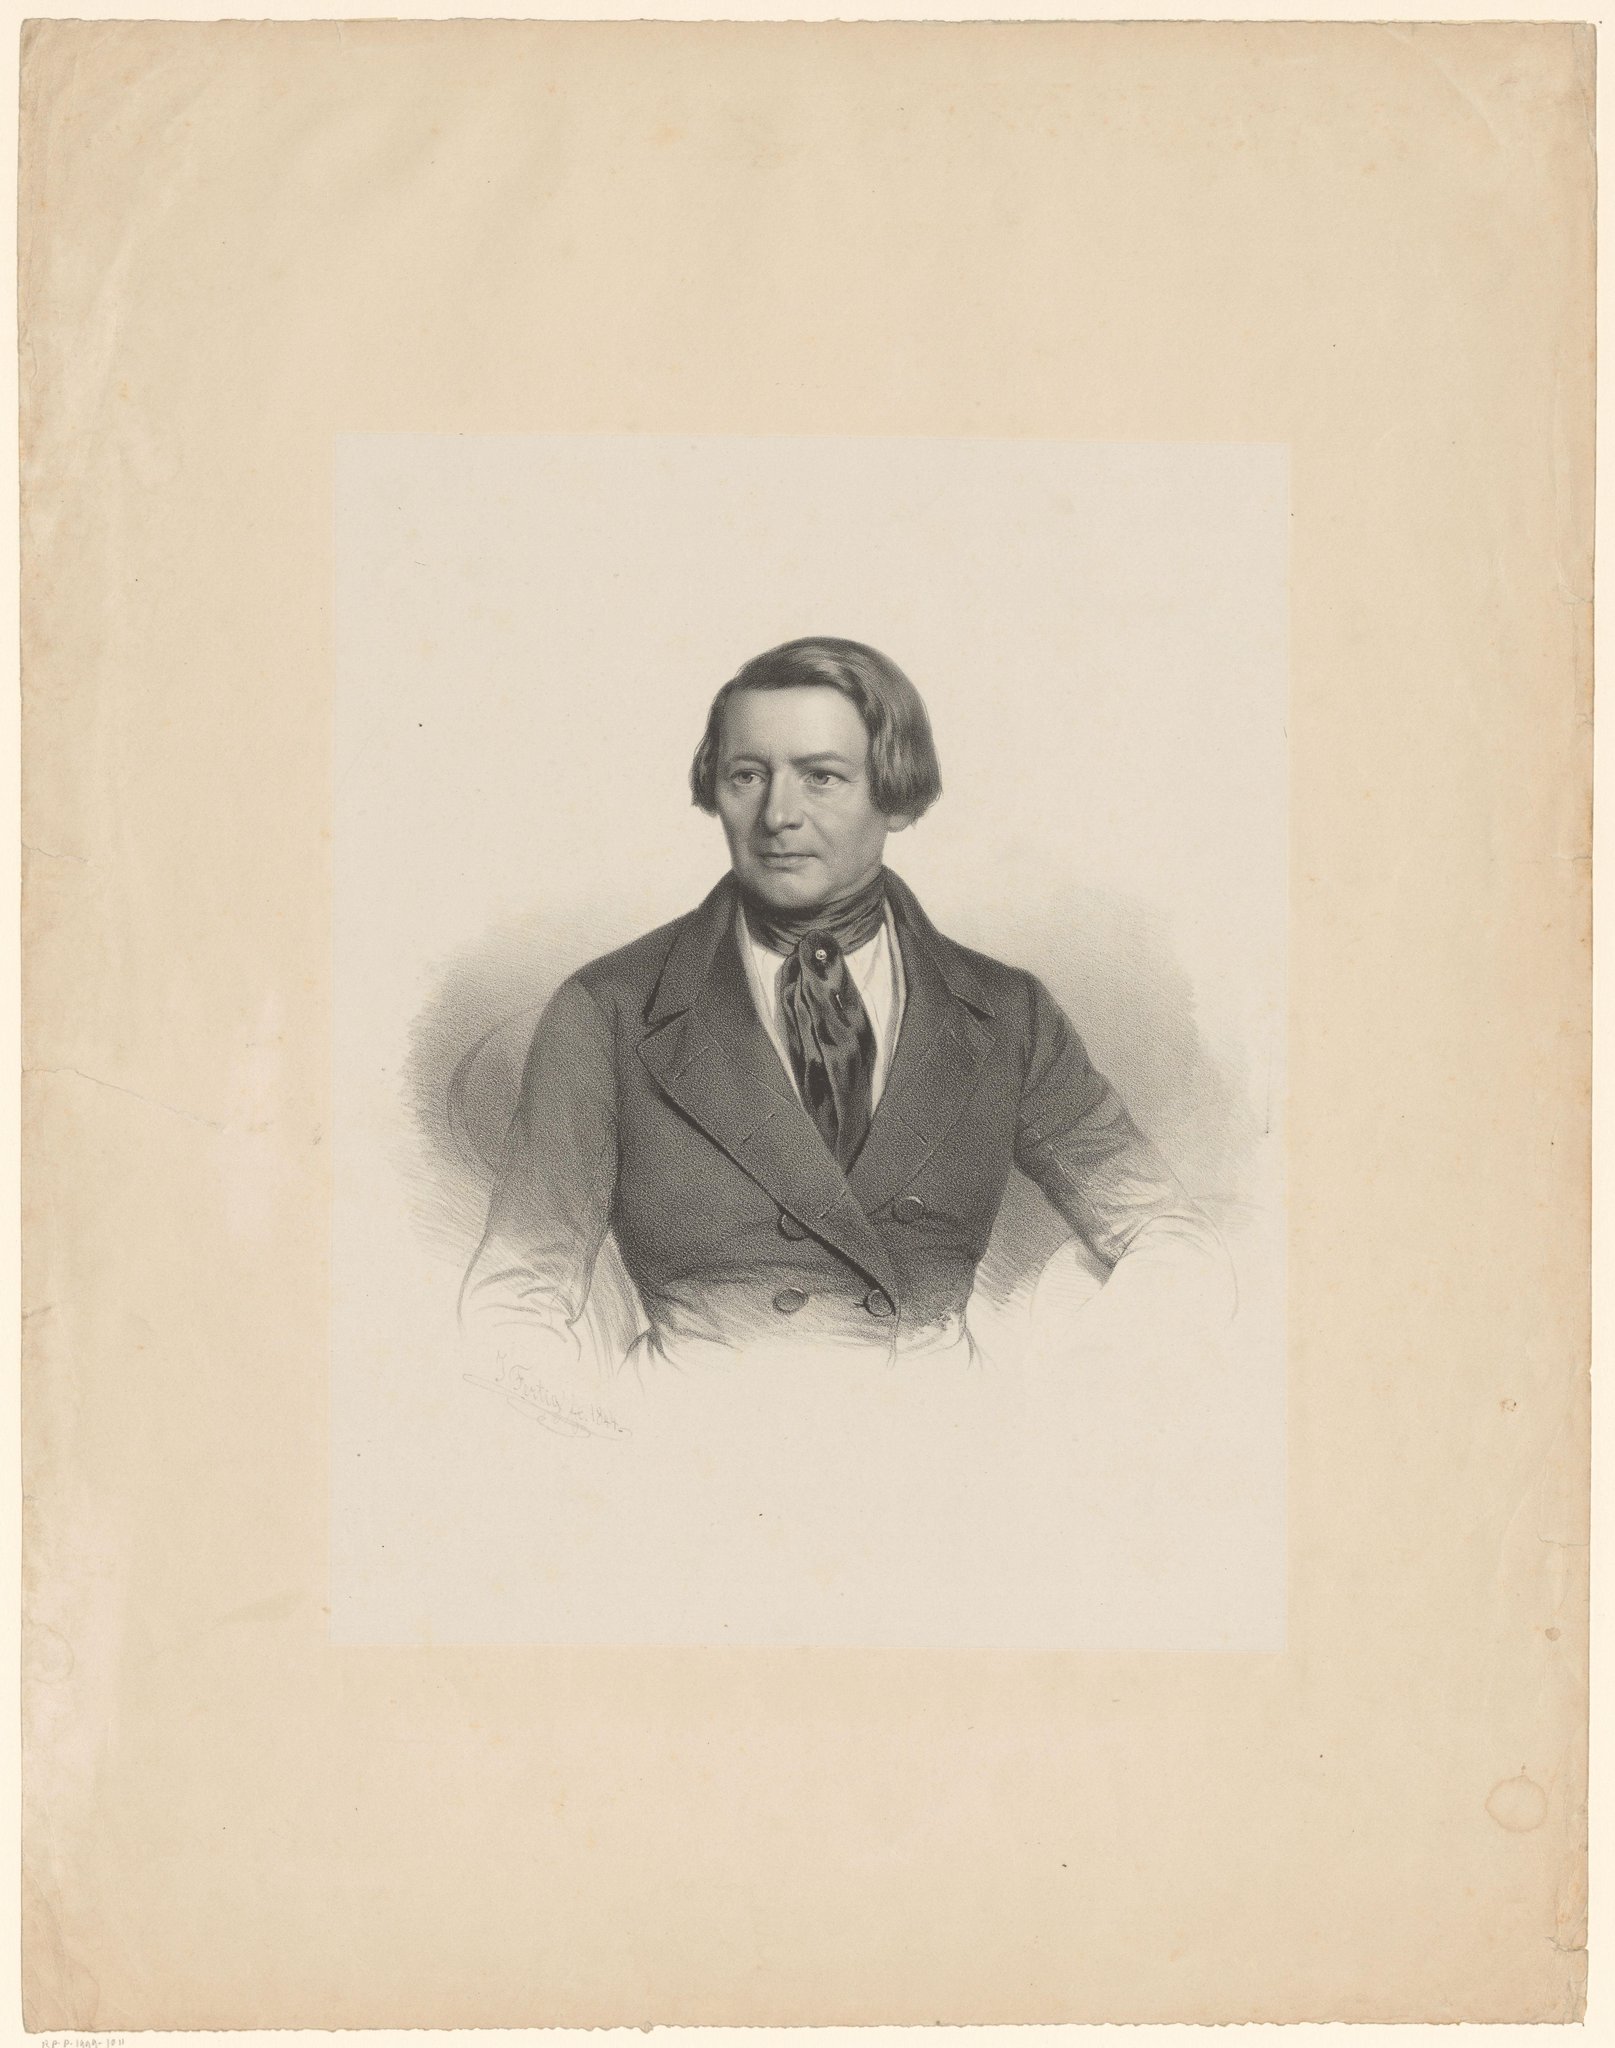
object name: print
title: Portret van een onbekende man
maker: ignaz fertig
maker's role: print maker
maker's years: 1809-1858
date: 1844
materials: paper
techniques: lithograph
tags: historical persons not known by name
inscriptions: collector's mark: Lugt 2228, collector's mark: Lugt 2760